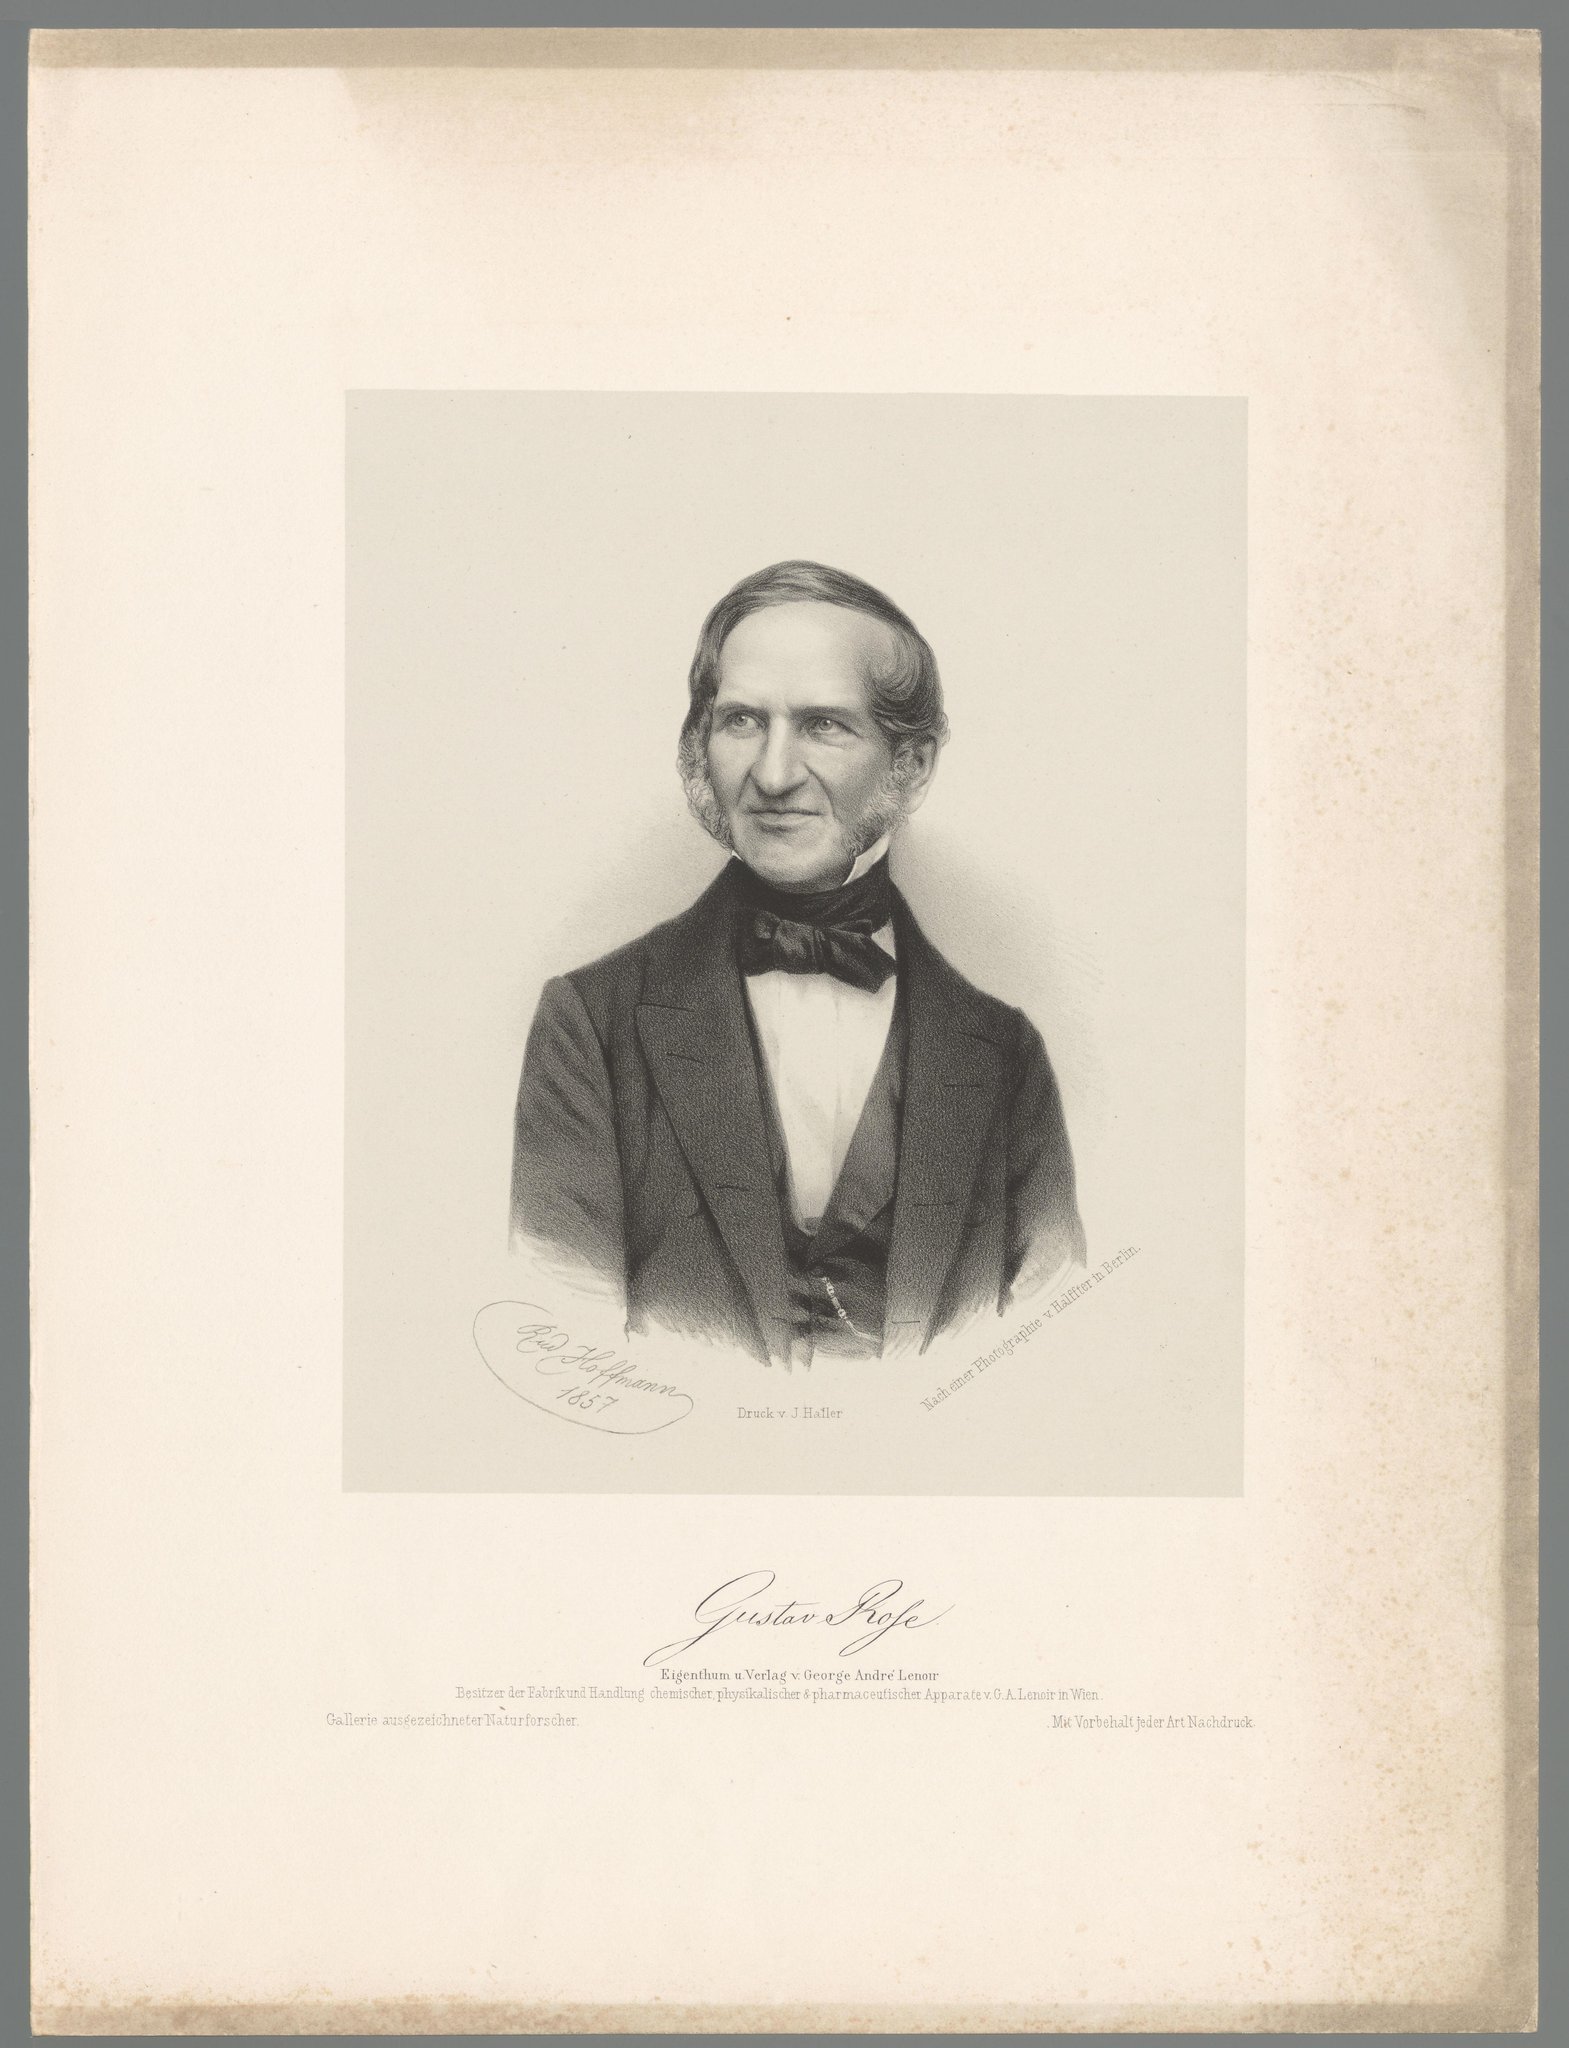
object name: print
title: Portret van Gustav Rose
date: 1857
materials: paper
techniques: lithograph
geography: berlin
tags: adult man, historical persons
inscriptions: collector's mark: Lugt 2228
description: Deze prent behoort tot een serie met 100 portretten van natuurwetenschappers, uitgegeven tussen 1856-1860.